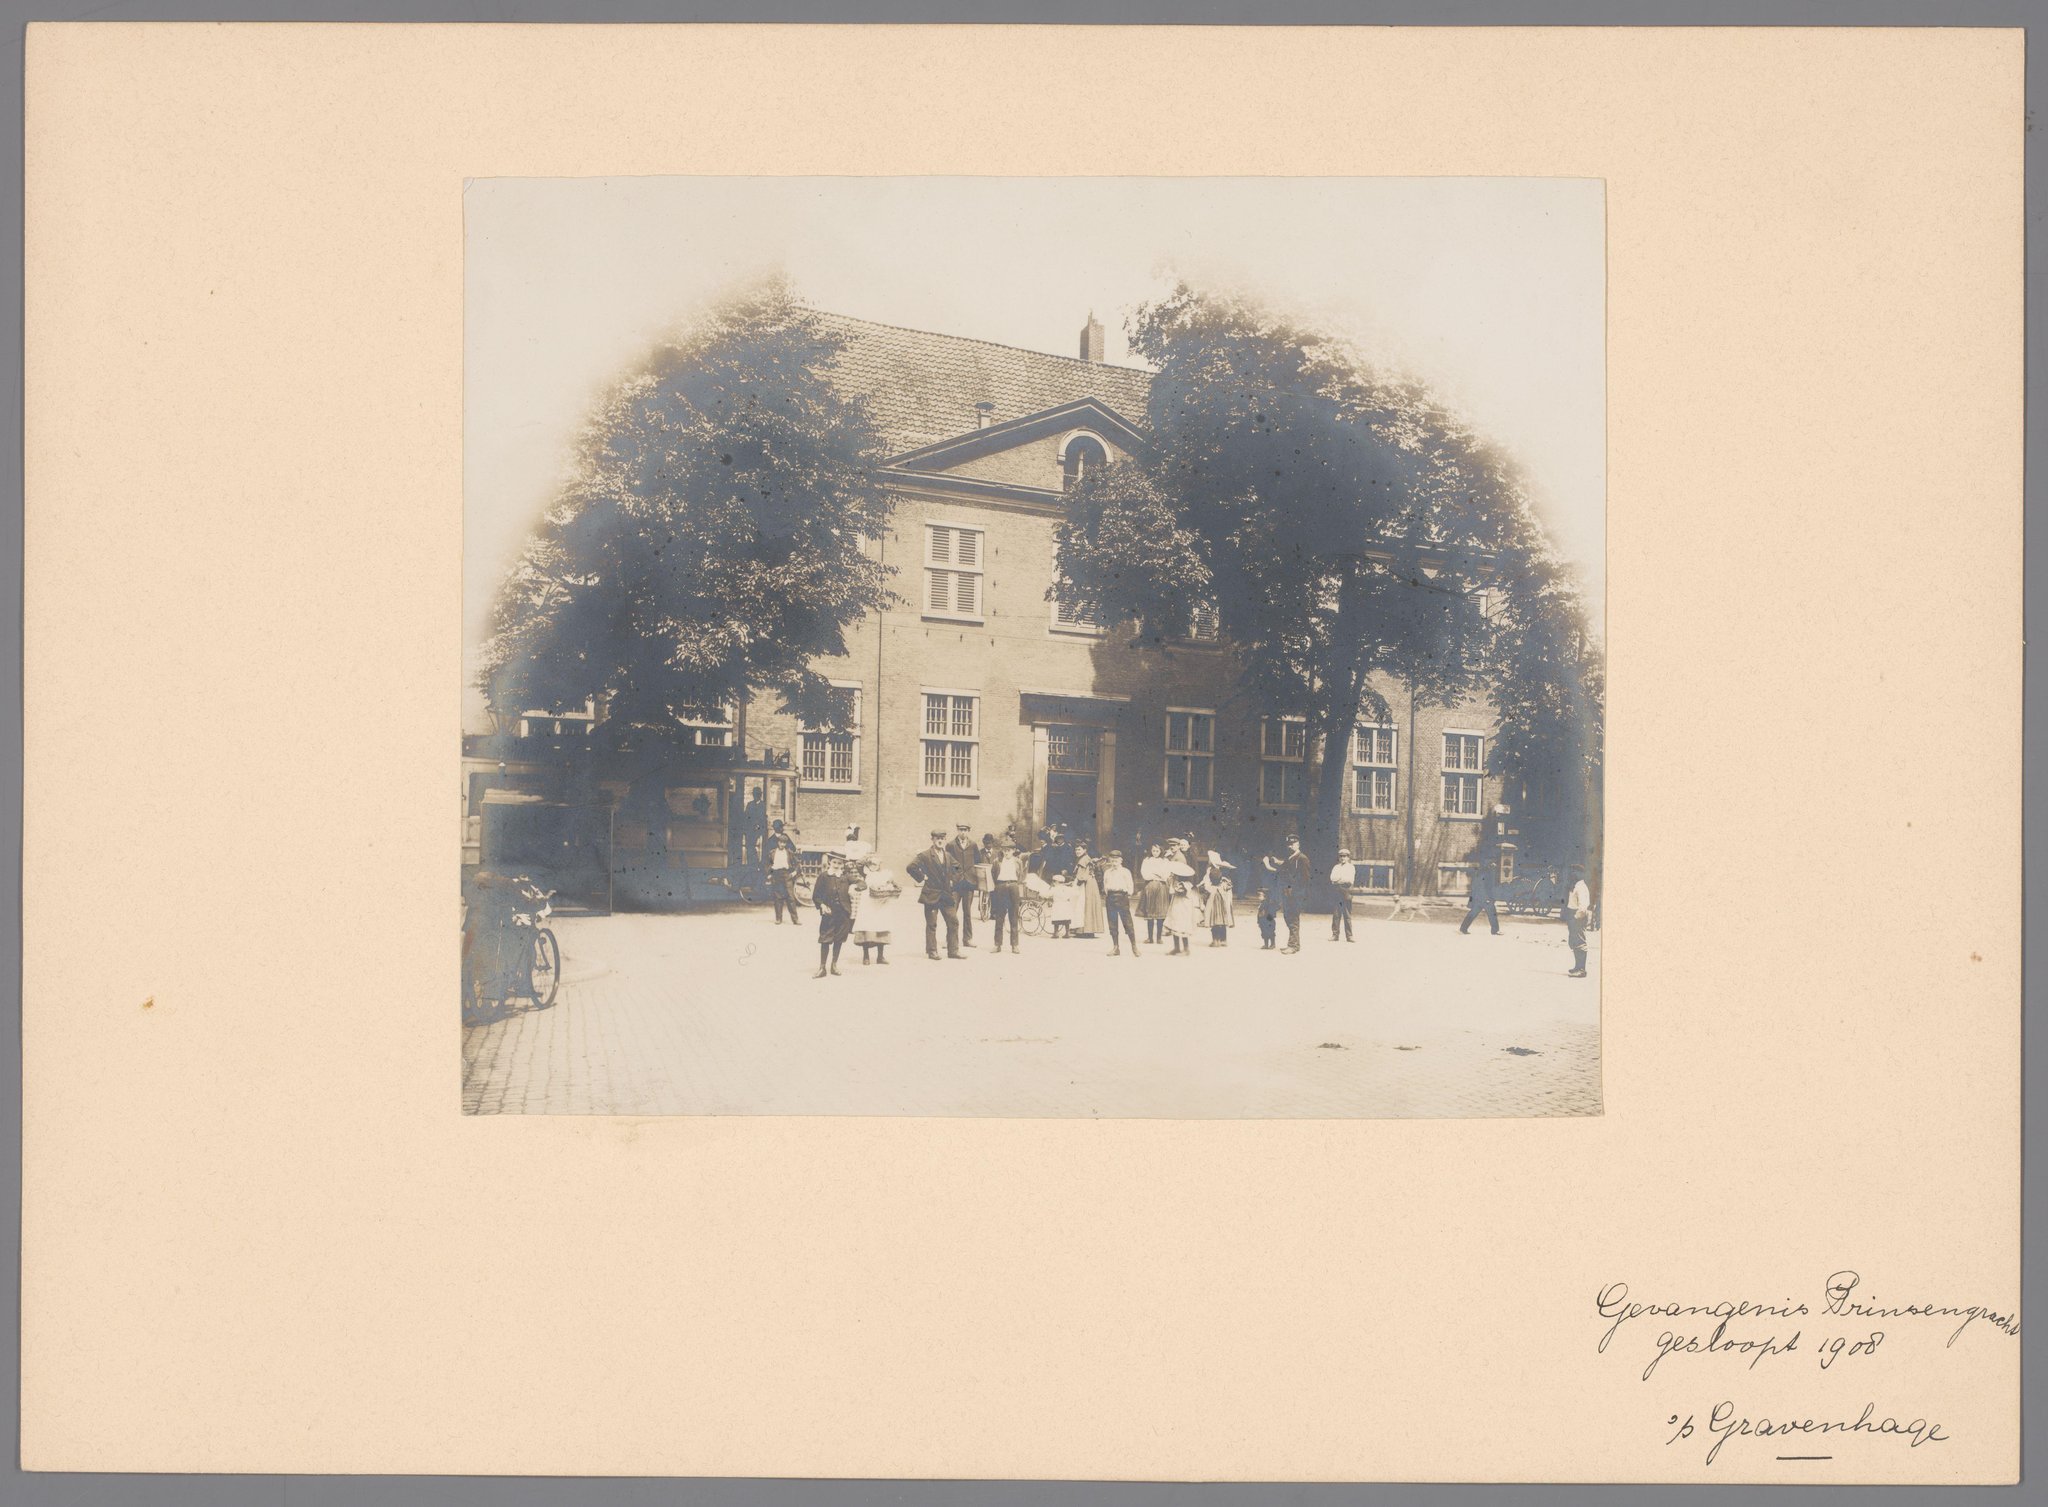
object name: photograph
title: Gezicht op de gevangenis op de Prinsegracht te Den Haag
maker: anoniem (monumentenzorg)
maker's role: fotograaf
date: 1900-1908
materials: cardboard, photographic support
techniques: gelatin silver print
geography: prinsegracht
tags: prison, jail, public road (+ city(-scape) with figures, staffage)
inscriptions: annotation: ‘Gevangenis Prinsengracht/ gesloopt 1908/ 's Gravenhage’, collector's mark: ‘R:MUS.’ Lugt 2228